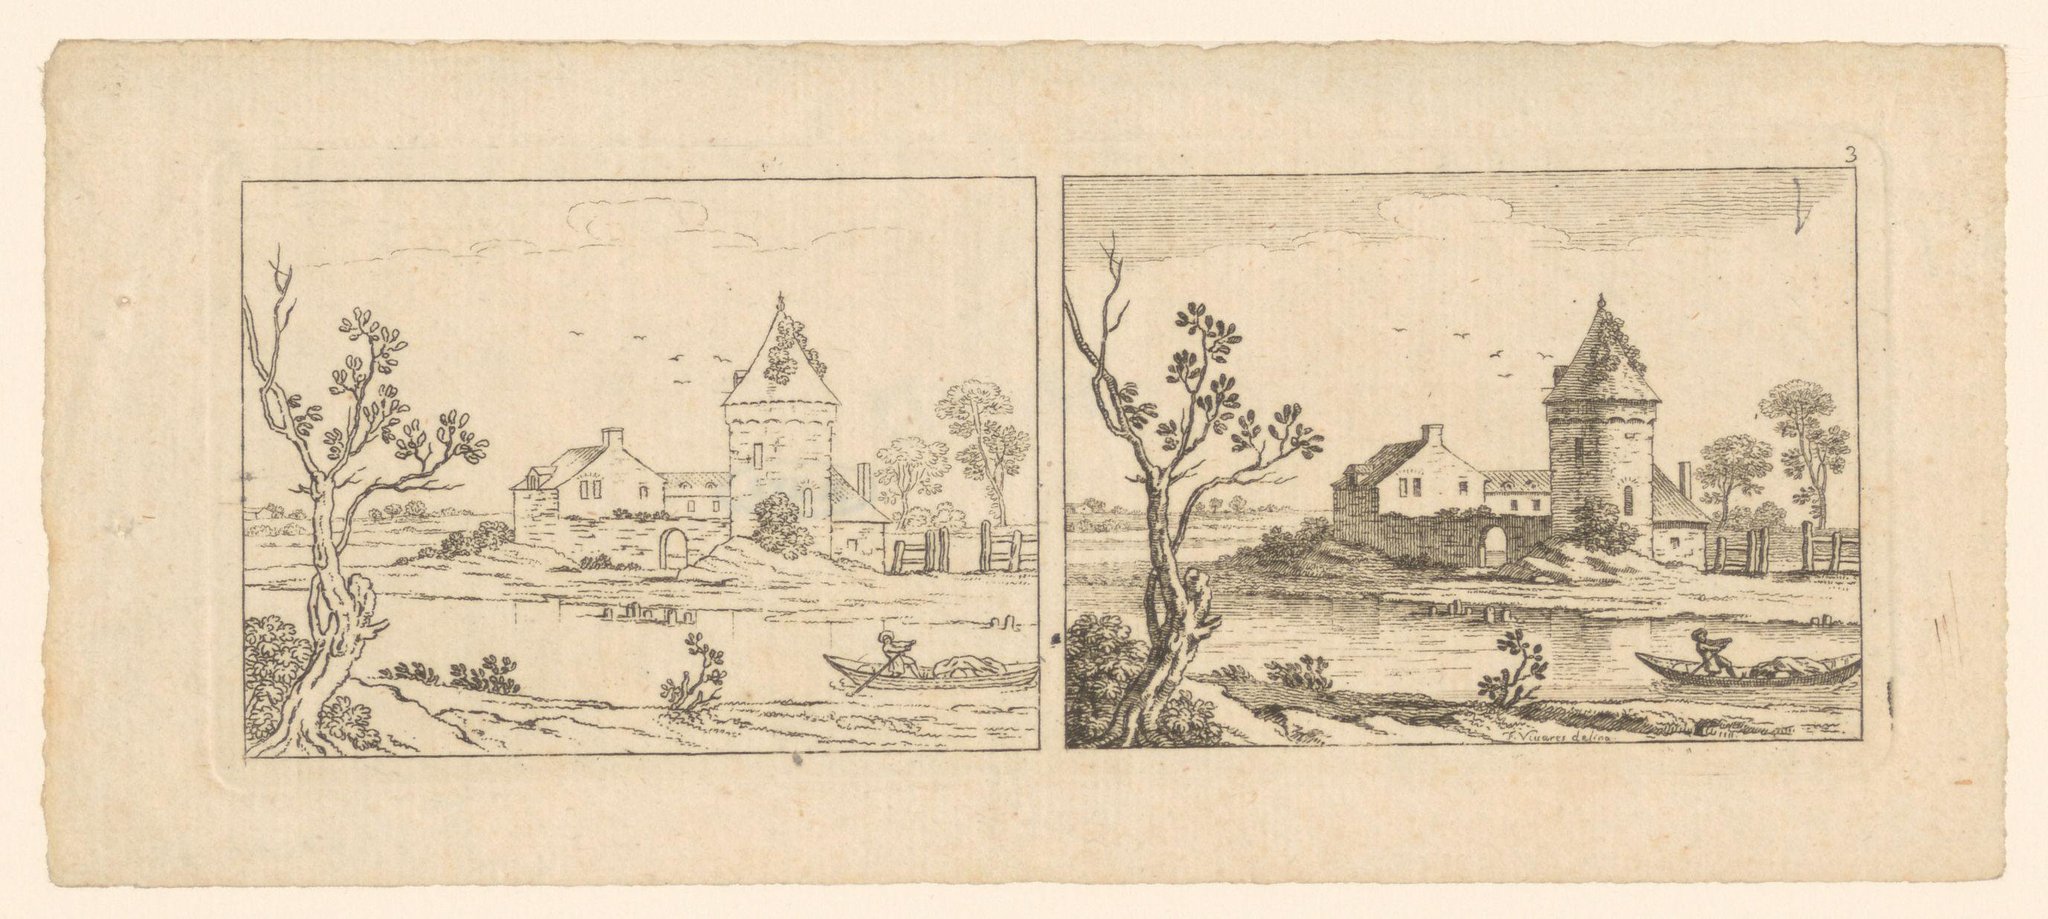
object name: print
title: Twee voorstellingen van hetzelfde landschap met een toren en een rivier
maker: françois vivares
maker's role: print maker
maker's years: 1709-1780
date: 1719-1780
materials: paper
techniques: etching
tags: river (+ landscape with figures, staffage), landscape with tower or castle (+ city(-scape) with figures, staffage)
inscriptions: collector's mark: Lugt 2228